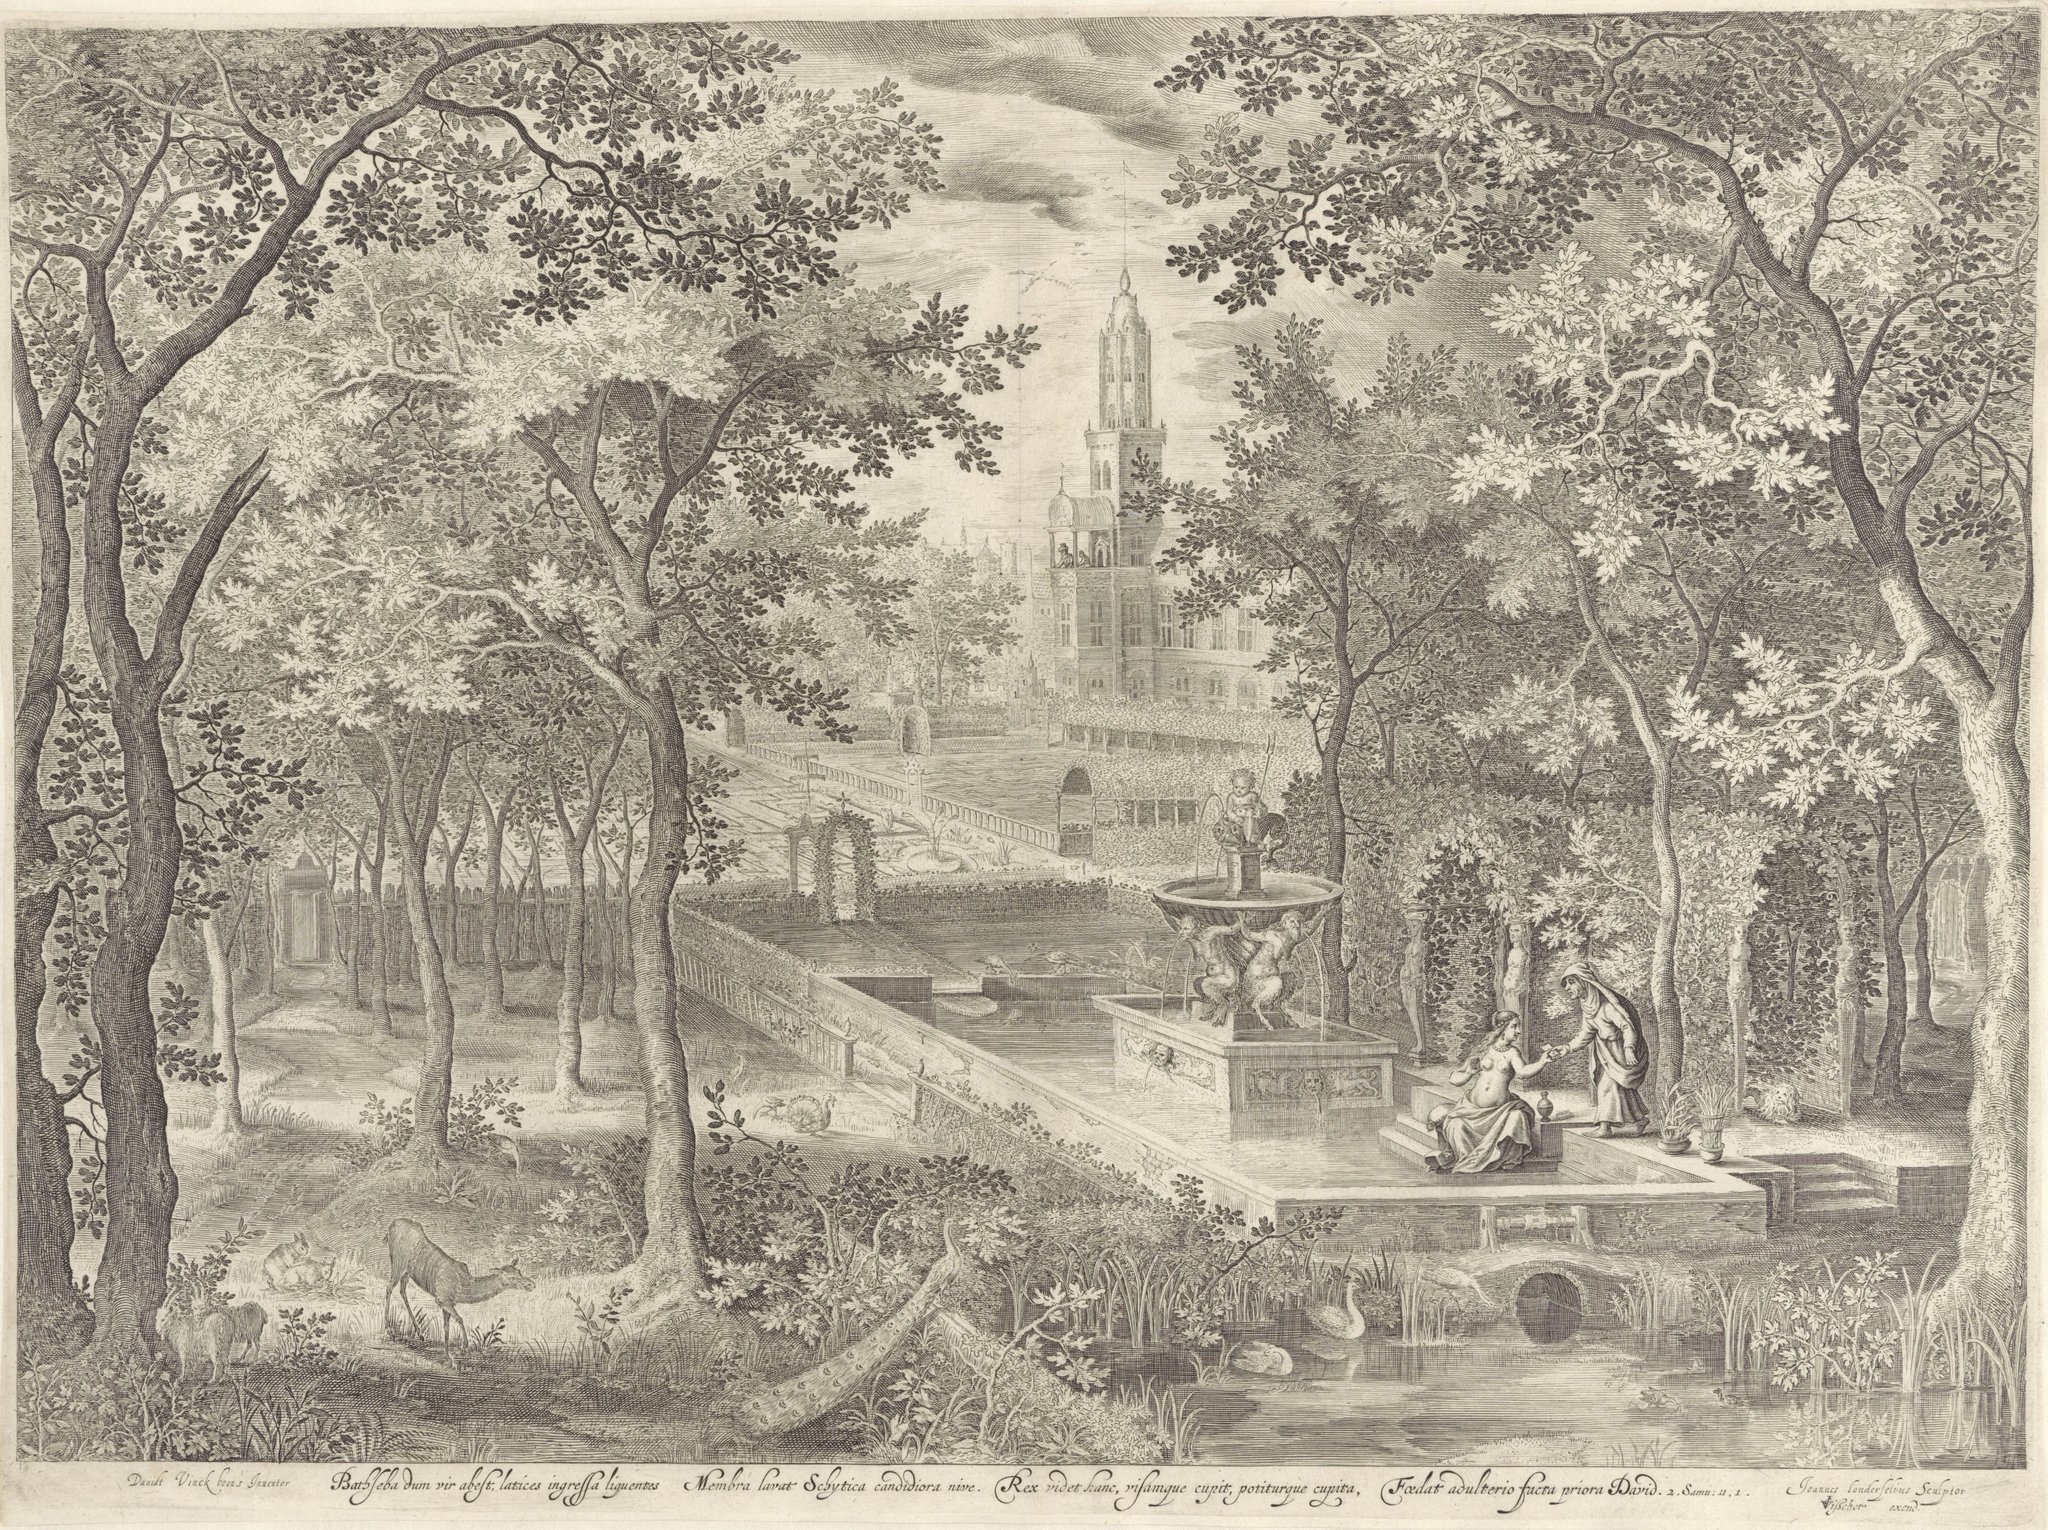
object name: print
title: Bathseba ontvangt de brief van David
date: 1601-1652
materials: paper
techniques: engraving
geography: amsterdam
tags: castle, susanna bathing, usually in or near a fountain and sometimes accompanied by two female servants, bathsheba receives a letter from david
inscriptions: collector's mark: Lugt 2228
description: Van deze prent is een eerdere staat bekend, getiteld "Susanna en de ouderlingen" (zie RP-P-1889-A-14667 en RP-P-1894-A-18602). De Amsterdamse uitgever Claes Jansz. Visscher (II) produceerde vanaf de jaren ’30 van de zeventiende eeuw grote Bijbelse prenten op zogenaamd royaal-formaat papier (ca. 480 x 580 mm). Na zijn dood in 1652 zette zijn zoon Nicolaes Visscher (I) het bedrijf voort en zo ook de uitgave van Royaalbijbelprenten. Toen Nicolaes in 1679 overleed nam zijn zoon Nicolaes Visscher (II) het bedrijf over en gaf kort hierna, omstreeks 1680, een fondslijst uit. Hierin worden 130 prenten met Bijbelse voorstellingen op royaalpapier beschreven (zie documentatie J. van der Waals). Complete prentbijbels op royaal-formaat werden door vader en zoon Nicolaes Visscher uitgegeven onder de titel Historiae Sacrae Veteris et Novi Testamenti. De bladen werden echter ook los verkocht en konden worden gecombineerd met Royaalbijbel-prenten van andere uitgevers. Verschillende Amsterdamse uitgevers brachten namelijk ook bijbelprenten op royaal-formaat uit, onder wie Clement de Jonghe en Cornelis Danckerts. De door de firma Visscher uitgegeven prenten zijn veelal vervaardigd door anonieme prentmakers naar voorbeeld van verschillende zestiende- en zeventiende-eeuwse Bijbelse prenten en prentreeksen. Veelal moesten de composities worden aangepast aan het grotere en langgerekte royaal-formaat. Daarnaast zijn er ook grote bladen van bekende prentmakers zoals Jan van Londerseel, Pieter Nolpe, Jacques de Gheyn (II) en Jan Harmensz. Muller opgenomen in de categorie ‘Bybelsche Figuren, op Royaal-bladen’ in de fondslijst van Visscher. Prent mogelijk gebruikt in: Historiae Sacrae Veteris et Novi Testamenti (Royaalbijbel). Amsterdam: Nicolaes Visscher (I) en (II), [1652-1702]. In de fondslijst van Nicolaes Visscher II (ca. 1680) is het onderwerp van deze prent onder de titel 'Bybelsche Figuren, op Royaal-bladen. bestaande uyt de volgende historien.' als volgt genummerd: 41.